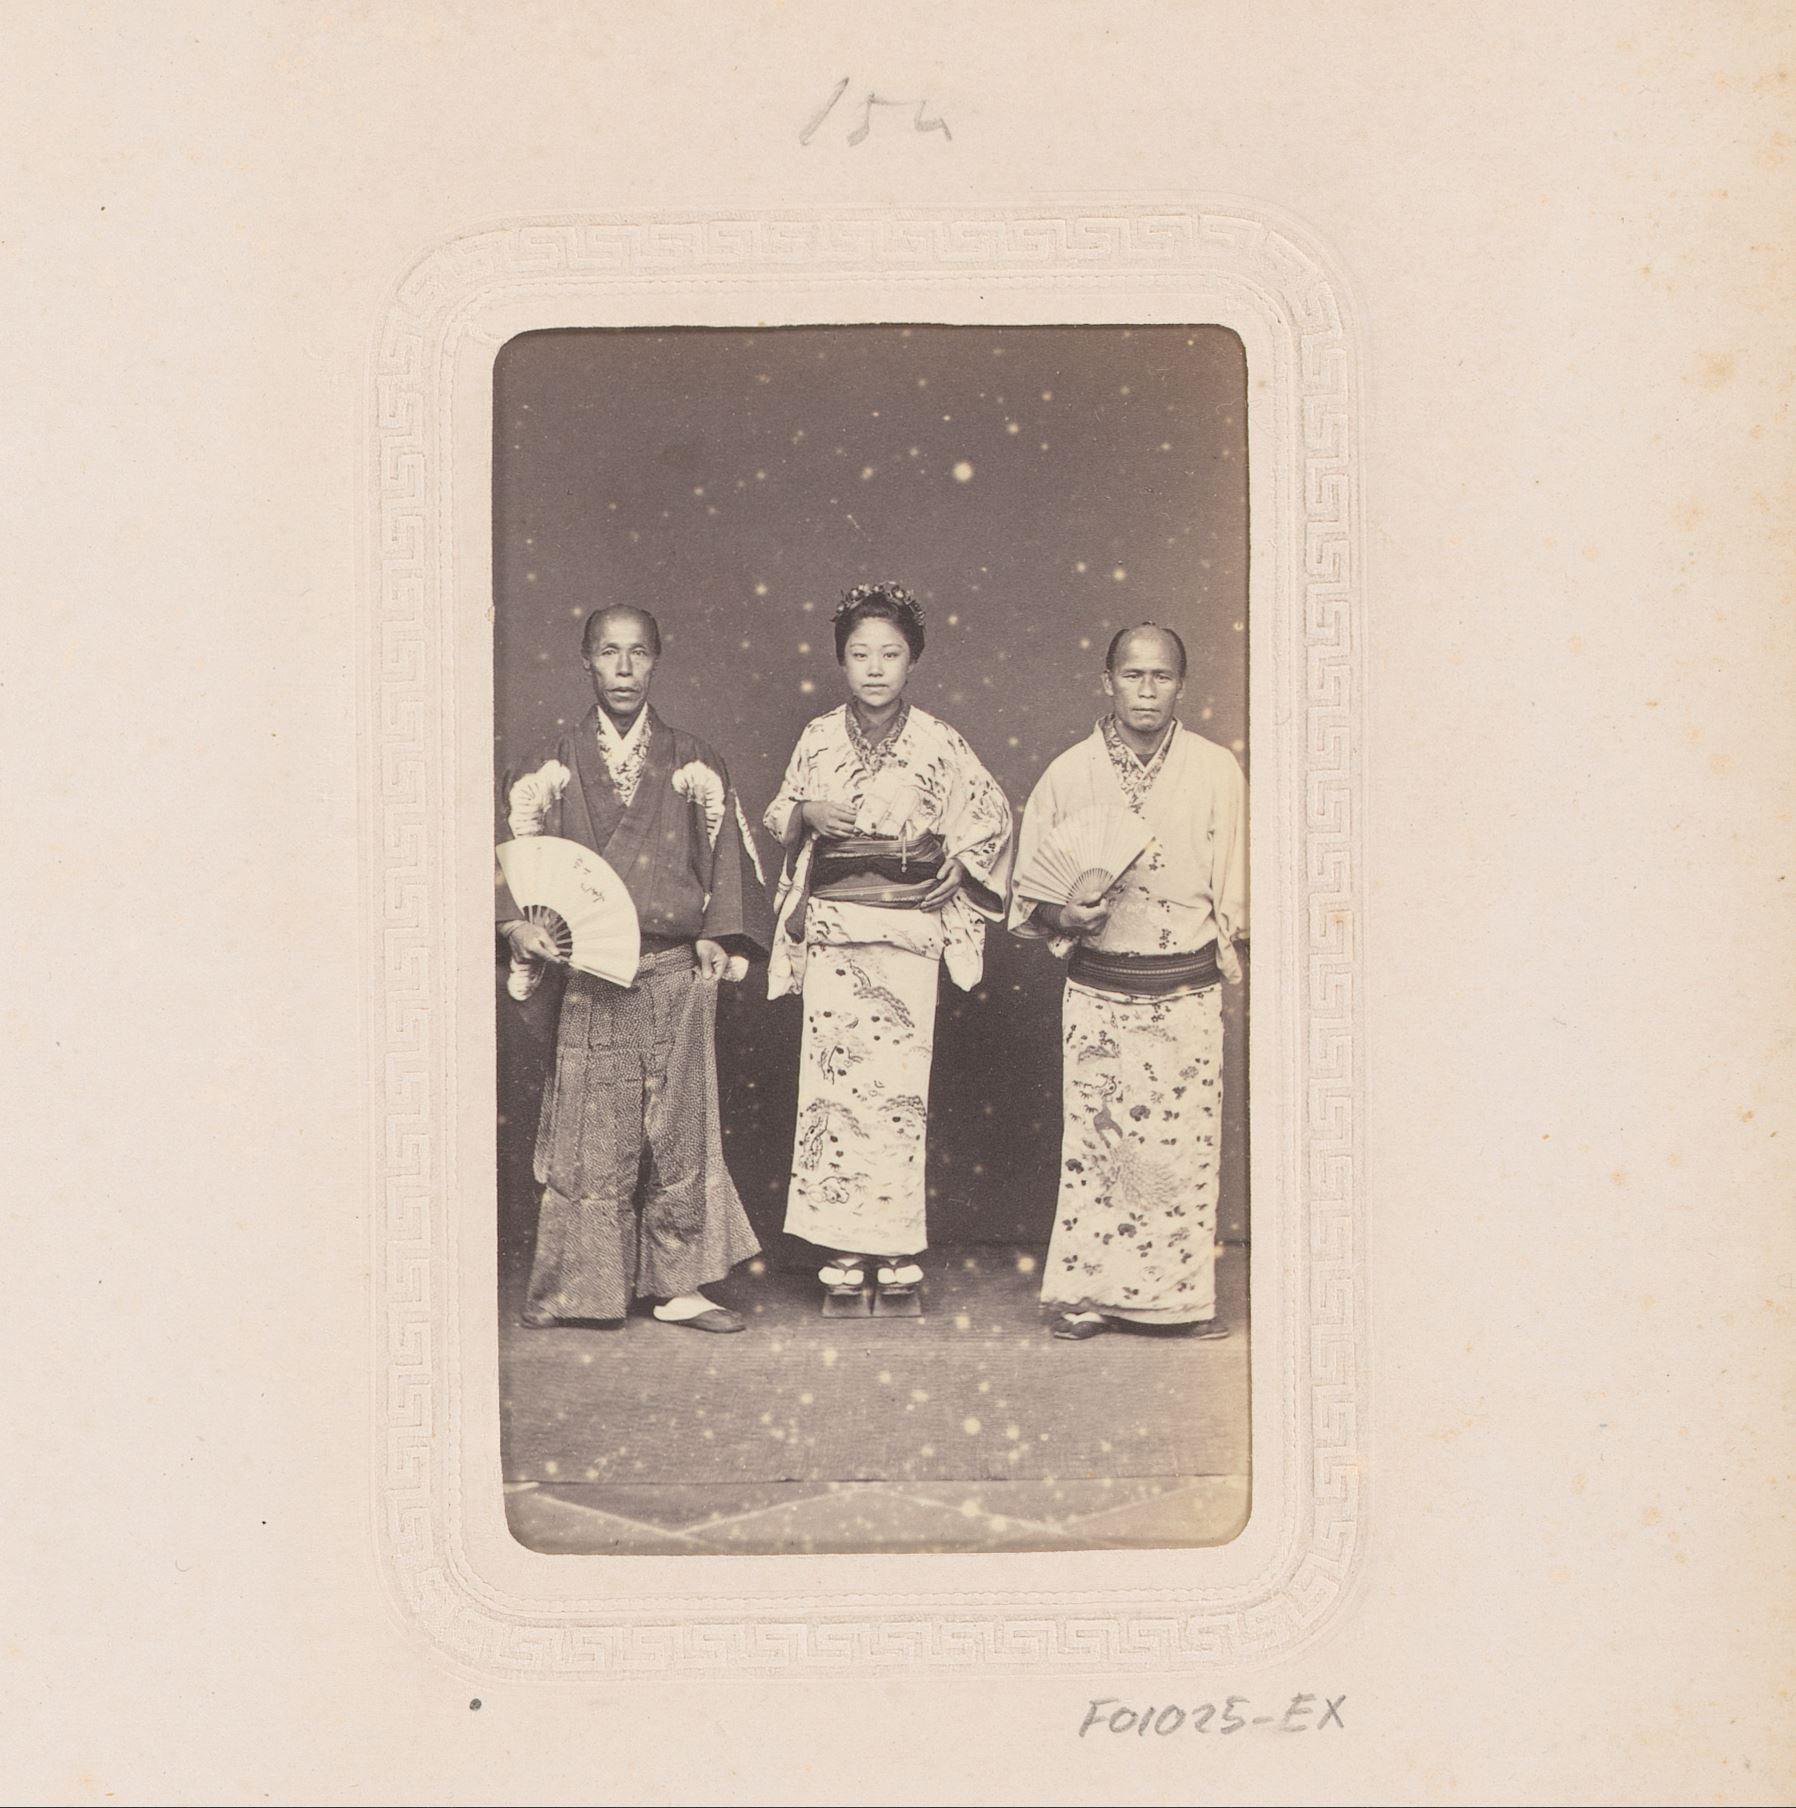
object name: photograph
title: Portret van twee Japanse mannen en een geisha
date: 1857-1880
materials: cardboard, photographic support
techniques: albumen print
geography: java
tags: historical persons, courtesan, hetaera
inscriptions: number: ‘154’, inscription: ‘Woodbury & Page/ Photographers/ Java’